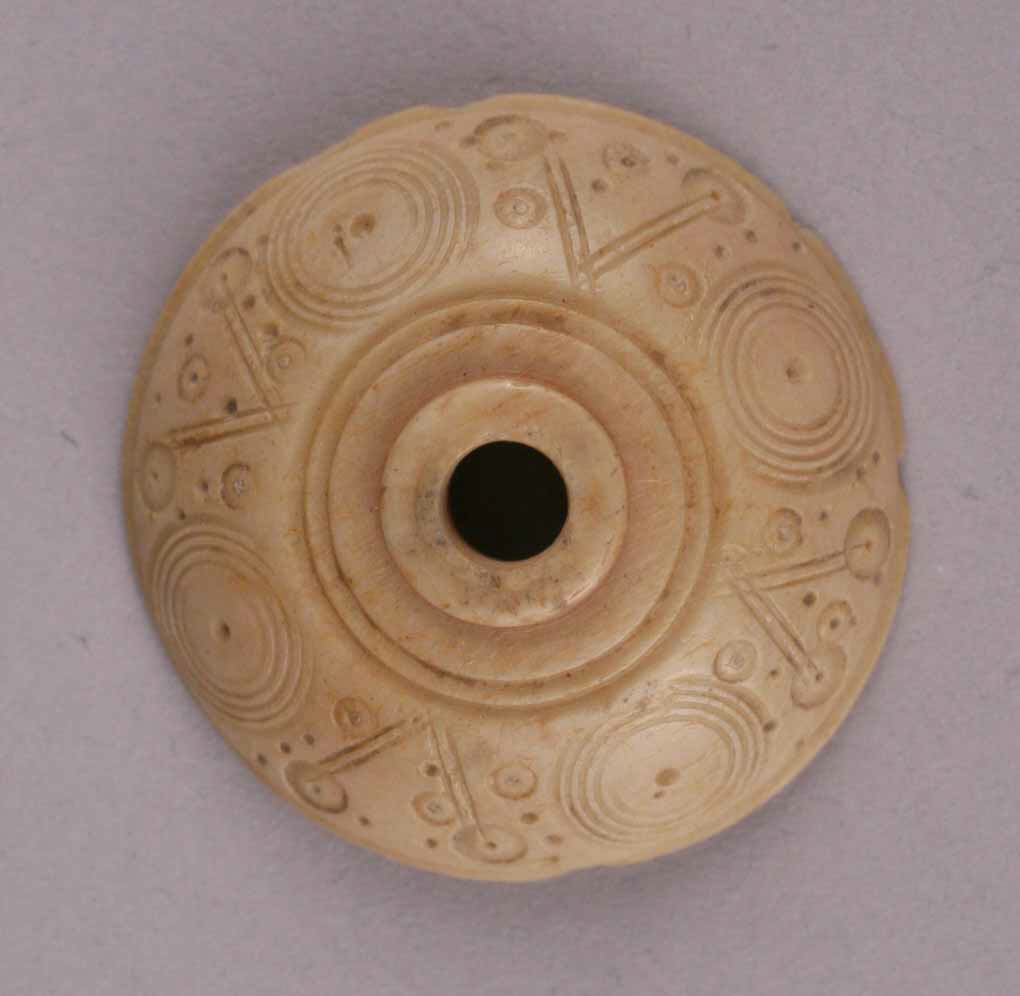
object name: spindle whorl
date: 801-1000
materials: bone, paint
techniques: incising, inlay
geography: iran